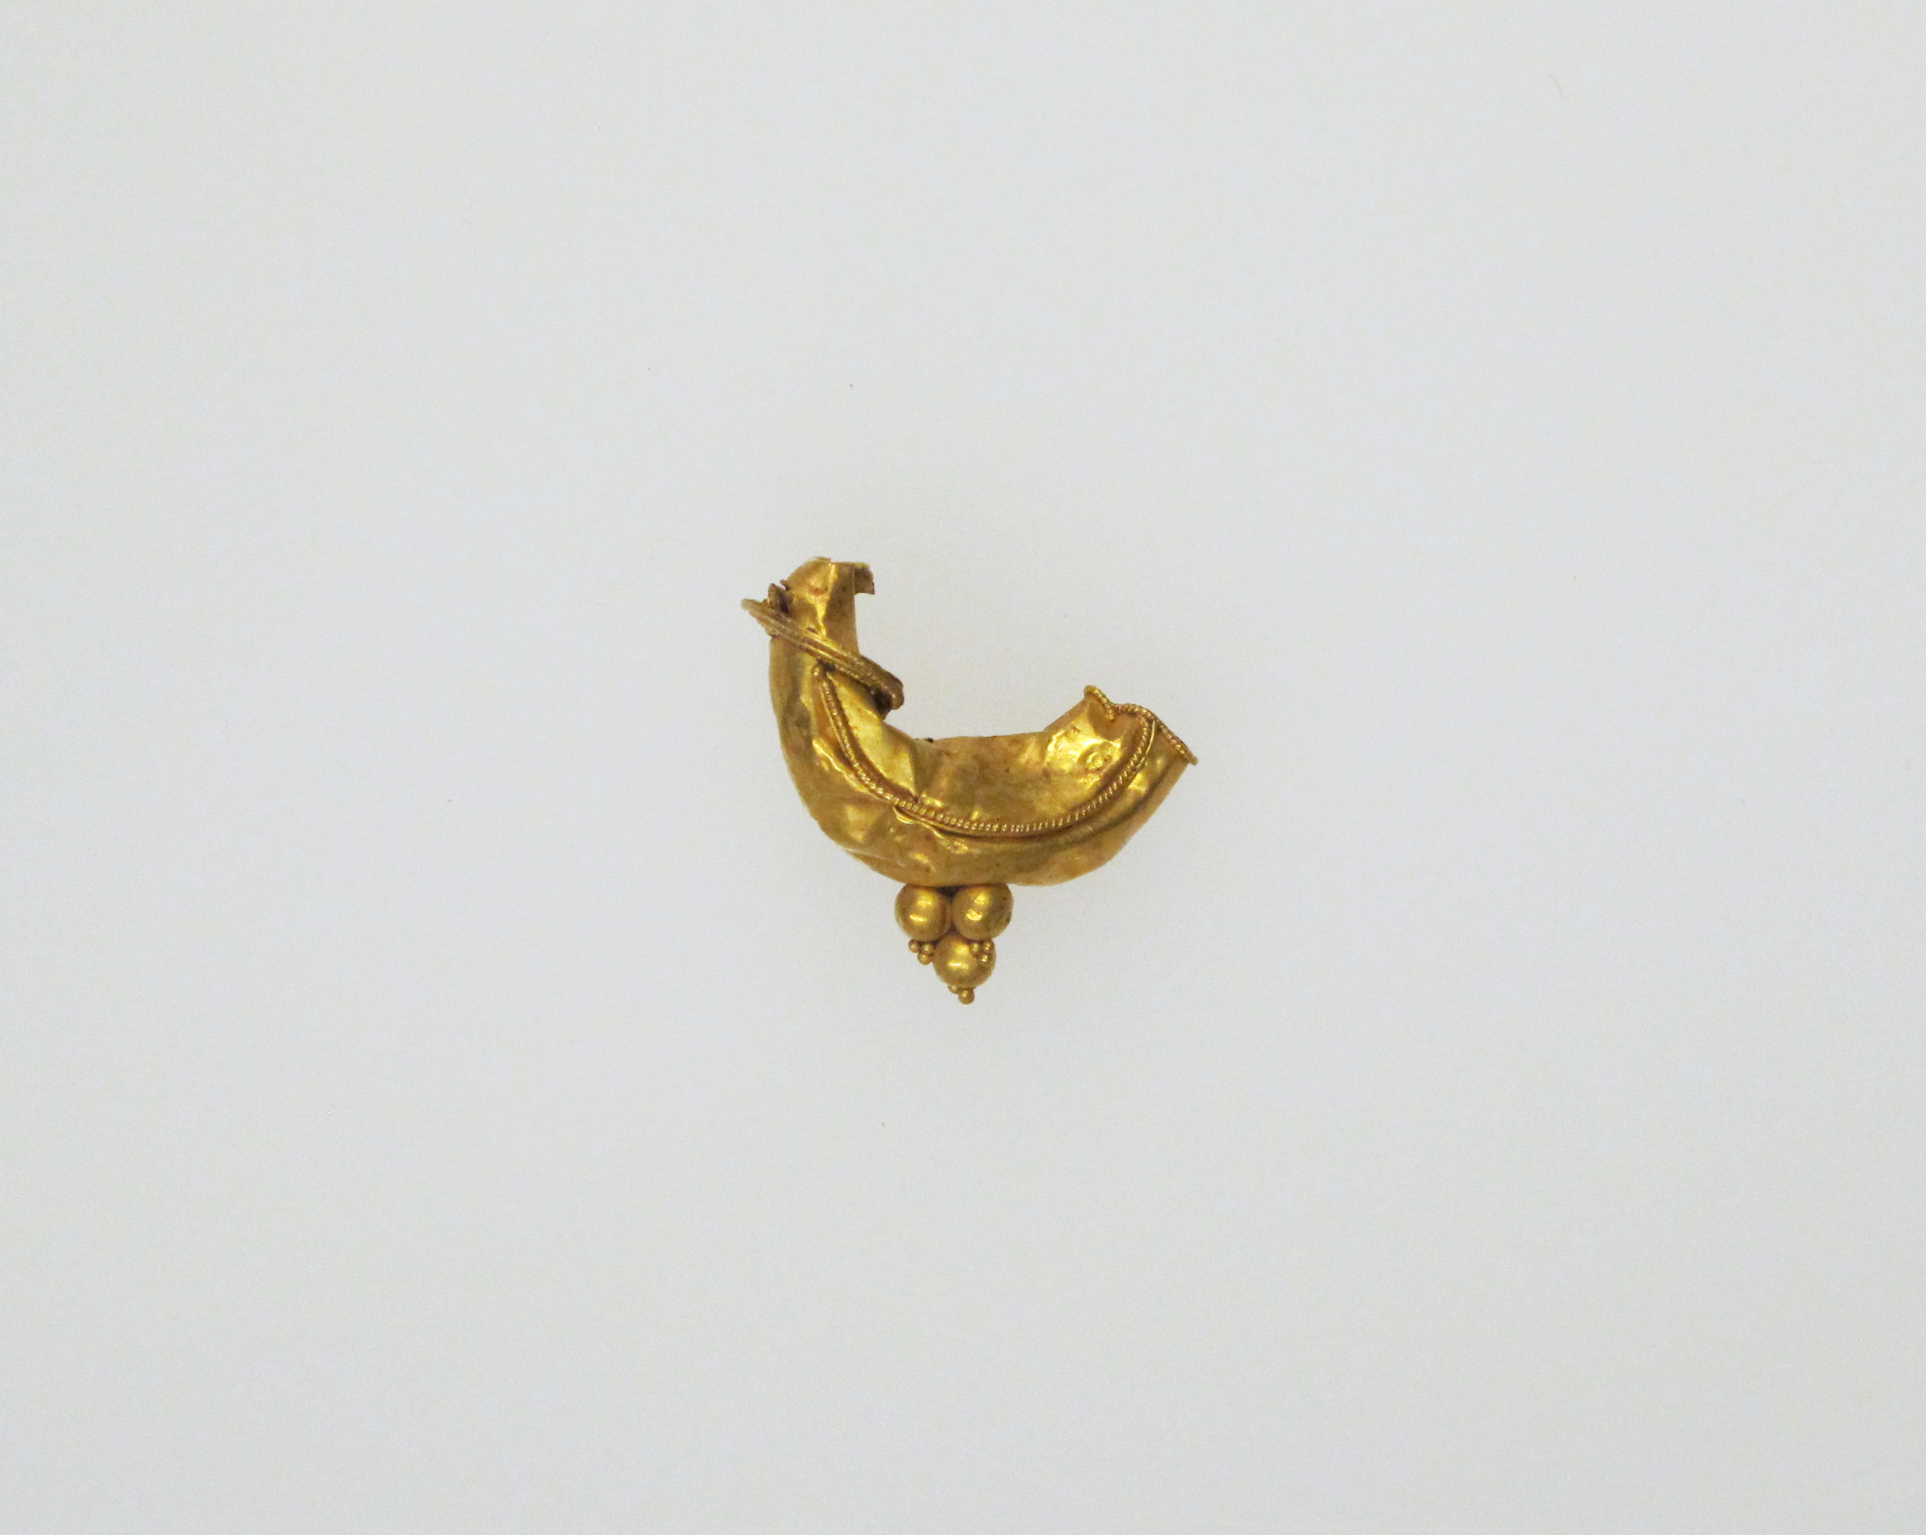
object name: earring, boat shaped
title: Earring, boat-shaped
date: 7000 BCE-330 CE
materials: gold